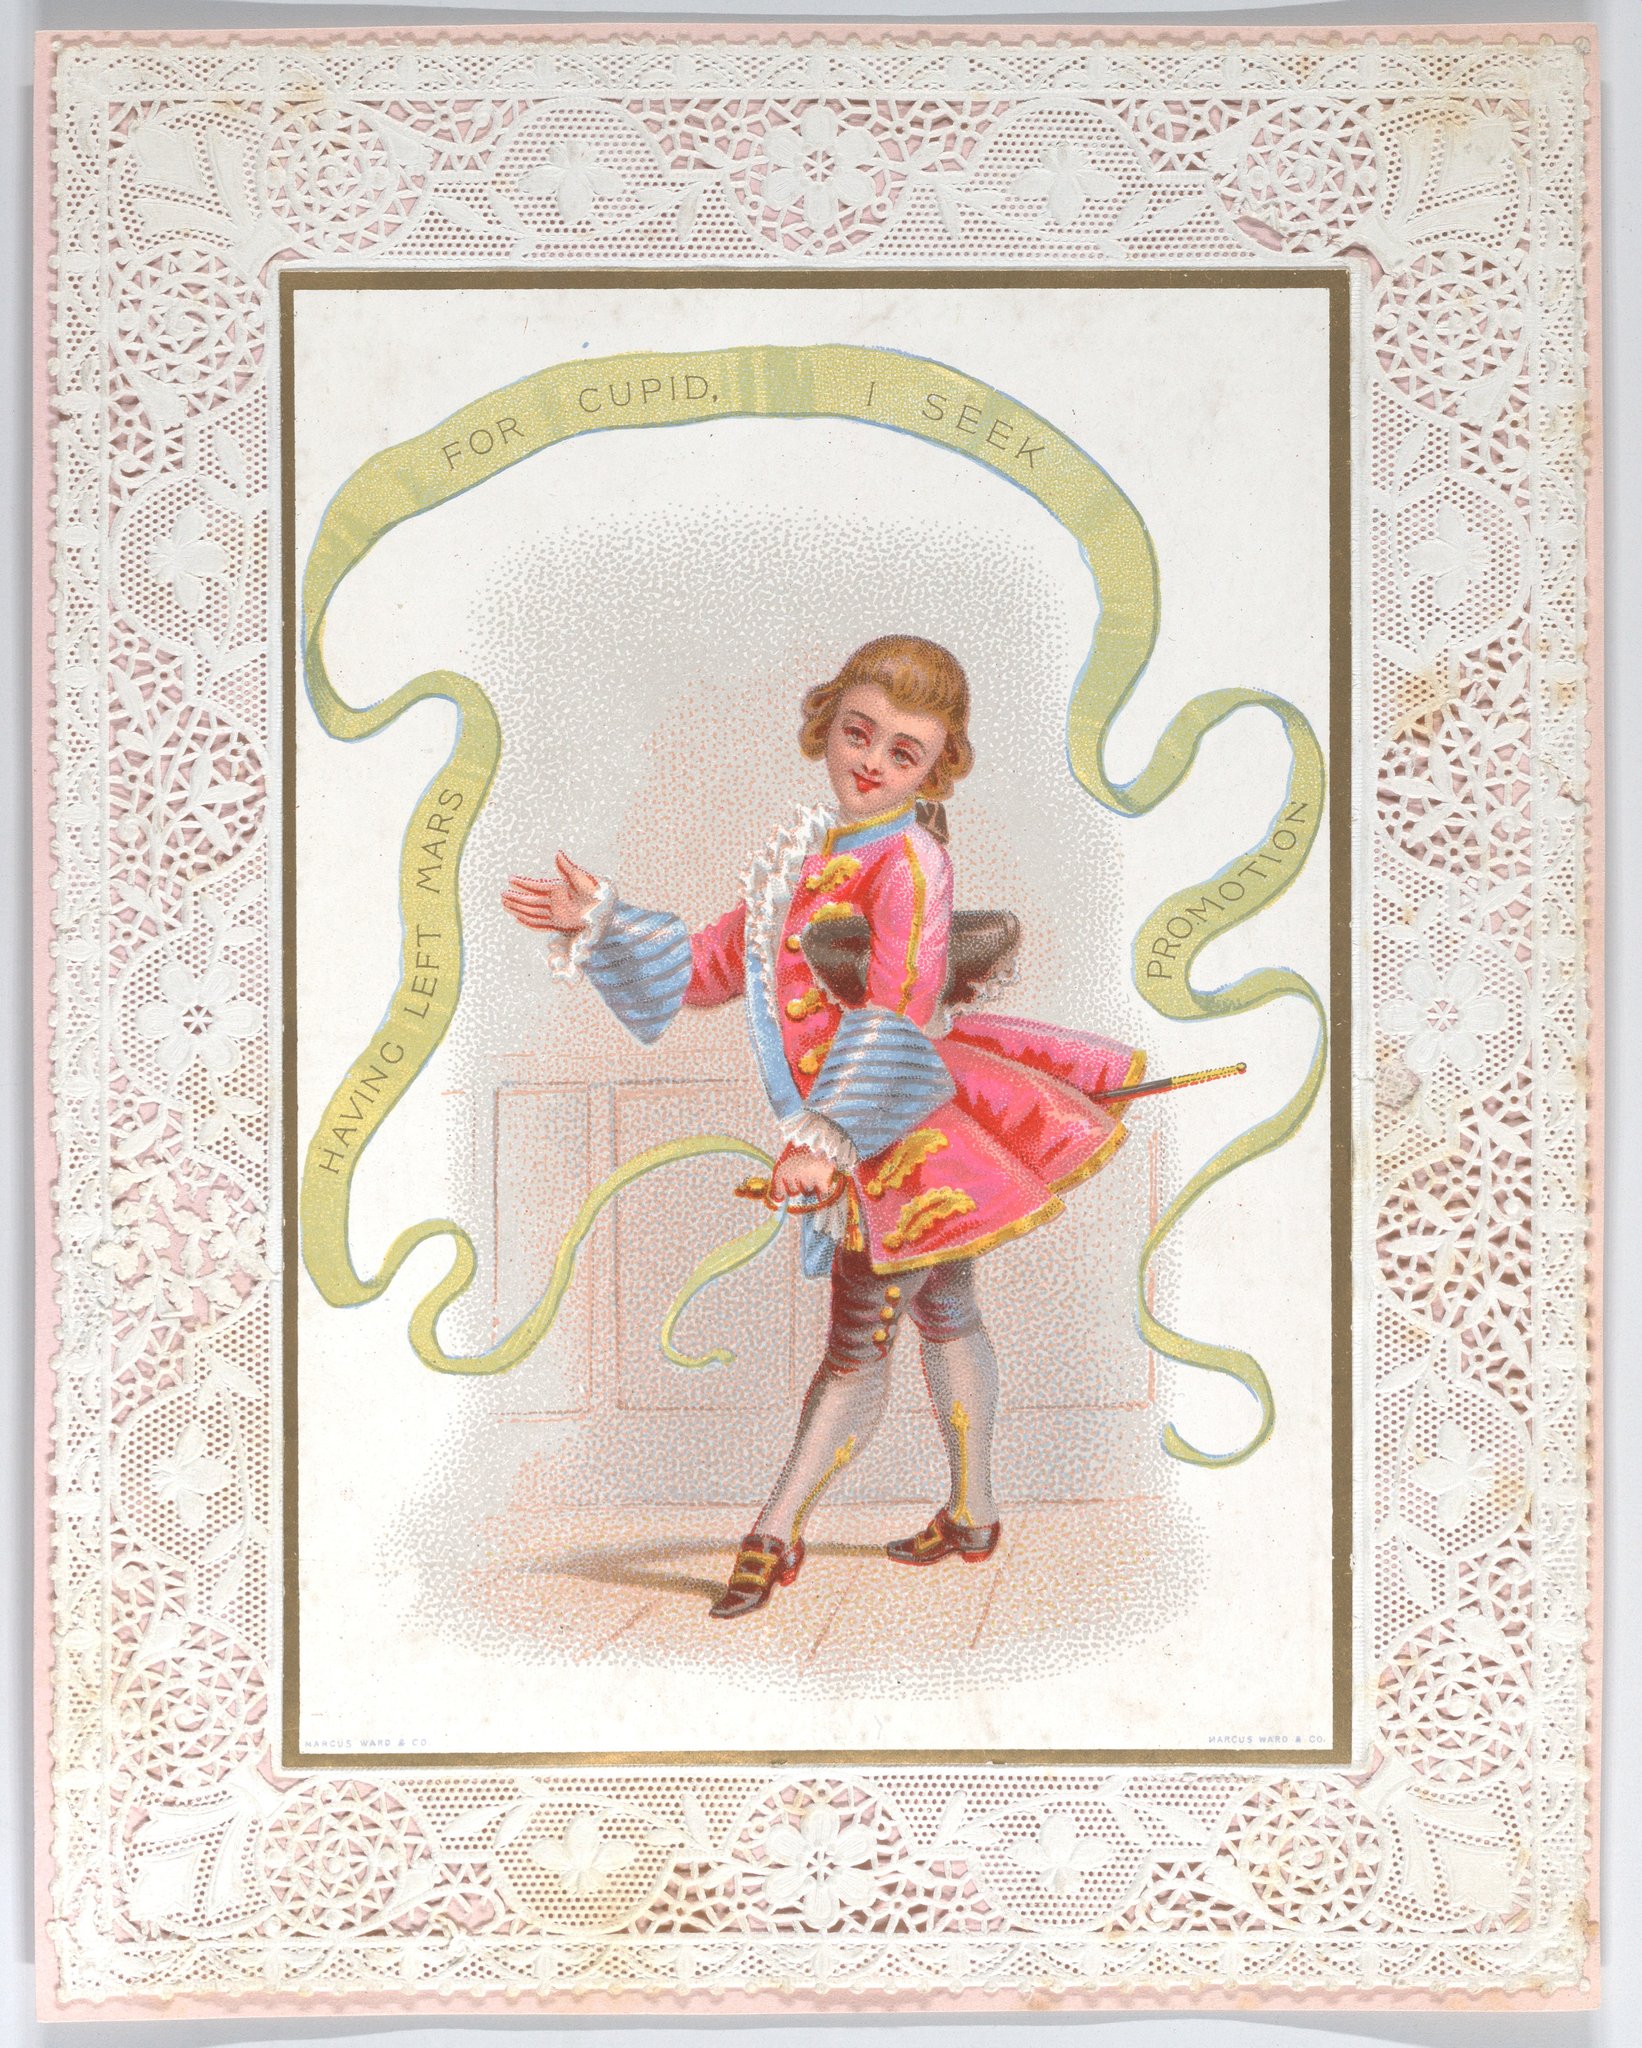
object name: valentine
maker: Anonymous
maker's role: artist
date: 1880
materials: gold, lace, paper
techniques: chromolithography, lithograph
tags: men